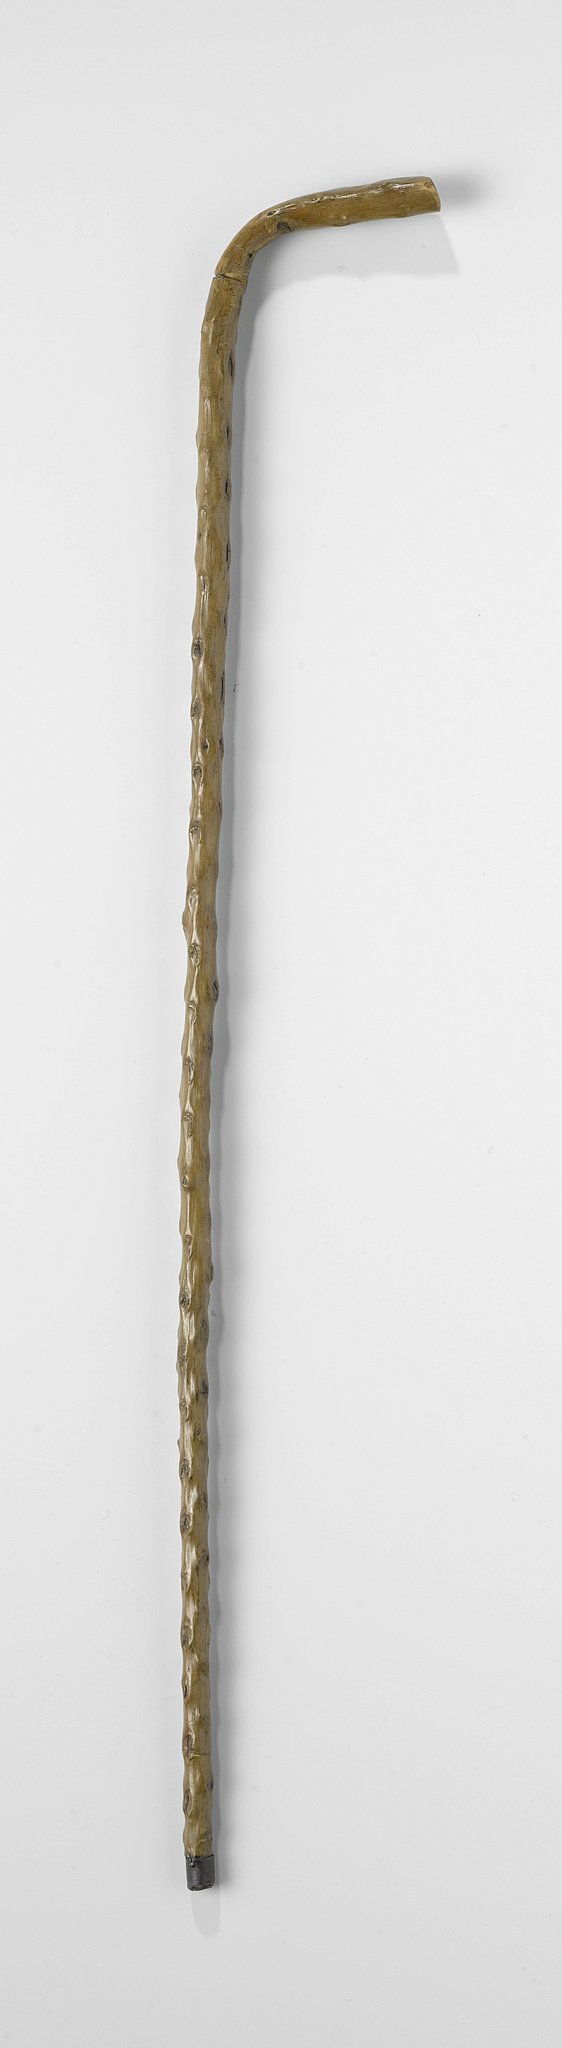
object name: walking stick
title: Walking stick with a straight handle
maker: Anonymous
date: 1795-1805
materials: wood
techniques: cutting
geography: netherlands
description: From 1795 the young and fashionable Incroyables in Paris used a gnarled branch as a walking stick. They nicknamed it the arbre de la liberté: tree of liberty, in reference to the French Revolution (1789). The Netherlands was rechristened the Batavian Republic on 19 January 1795. A liberty tree was raised in Amsterdam on the ‘Plein der Revolutie’, Dam Square. Whether the stick was dubbed the same in the Netherlands is unknown.